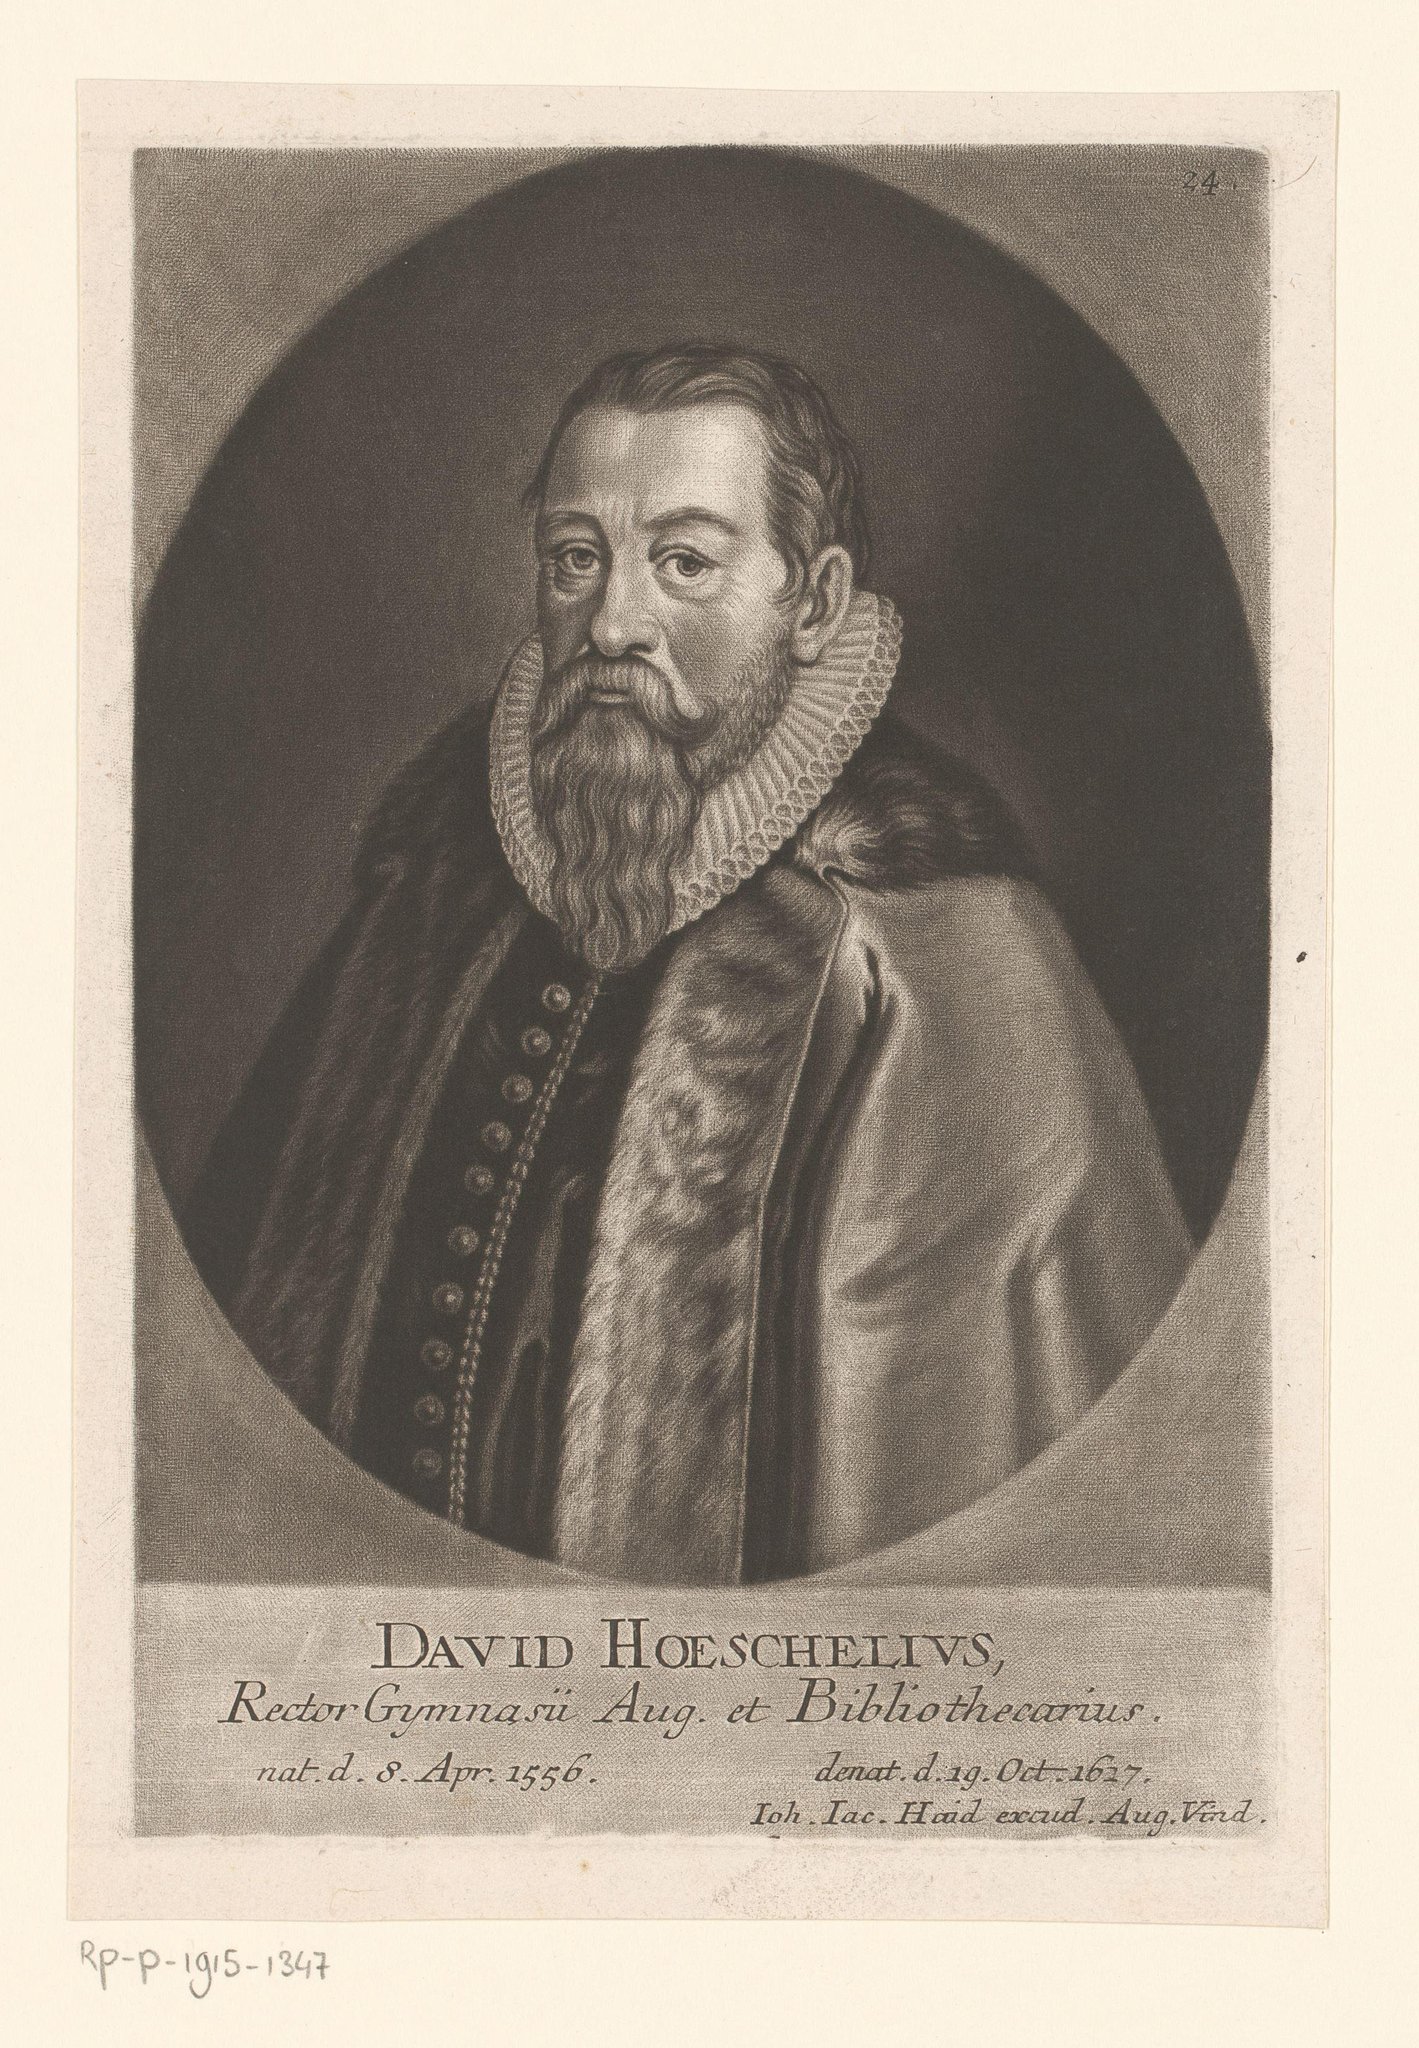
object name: print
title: Portret van David Hoeschelius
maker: johann jacob haid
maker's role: print maker, publisher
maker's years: 1704-1767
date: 1747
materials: paper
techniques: mezzotint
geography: augsburg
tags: augsburg, historical persons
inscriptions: collector's mark: Lugt 2228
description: Prent gebruikt voor: Brucker, Jacob. Ehrentempel der Deutschen Gelehrsamkeit. Augsburg: Johann Jacob Haid, 1747.